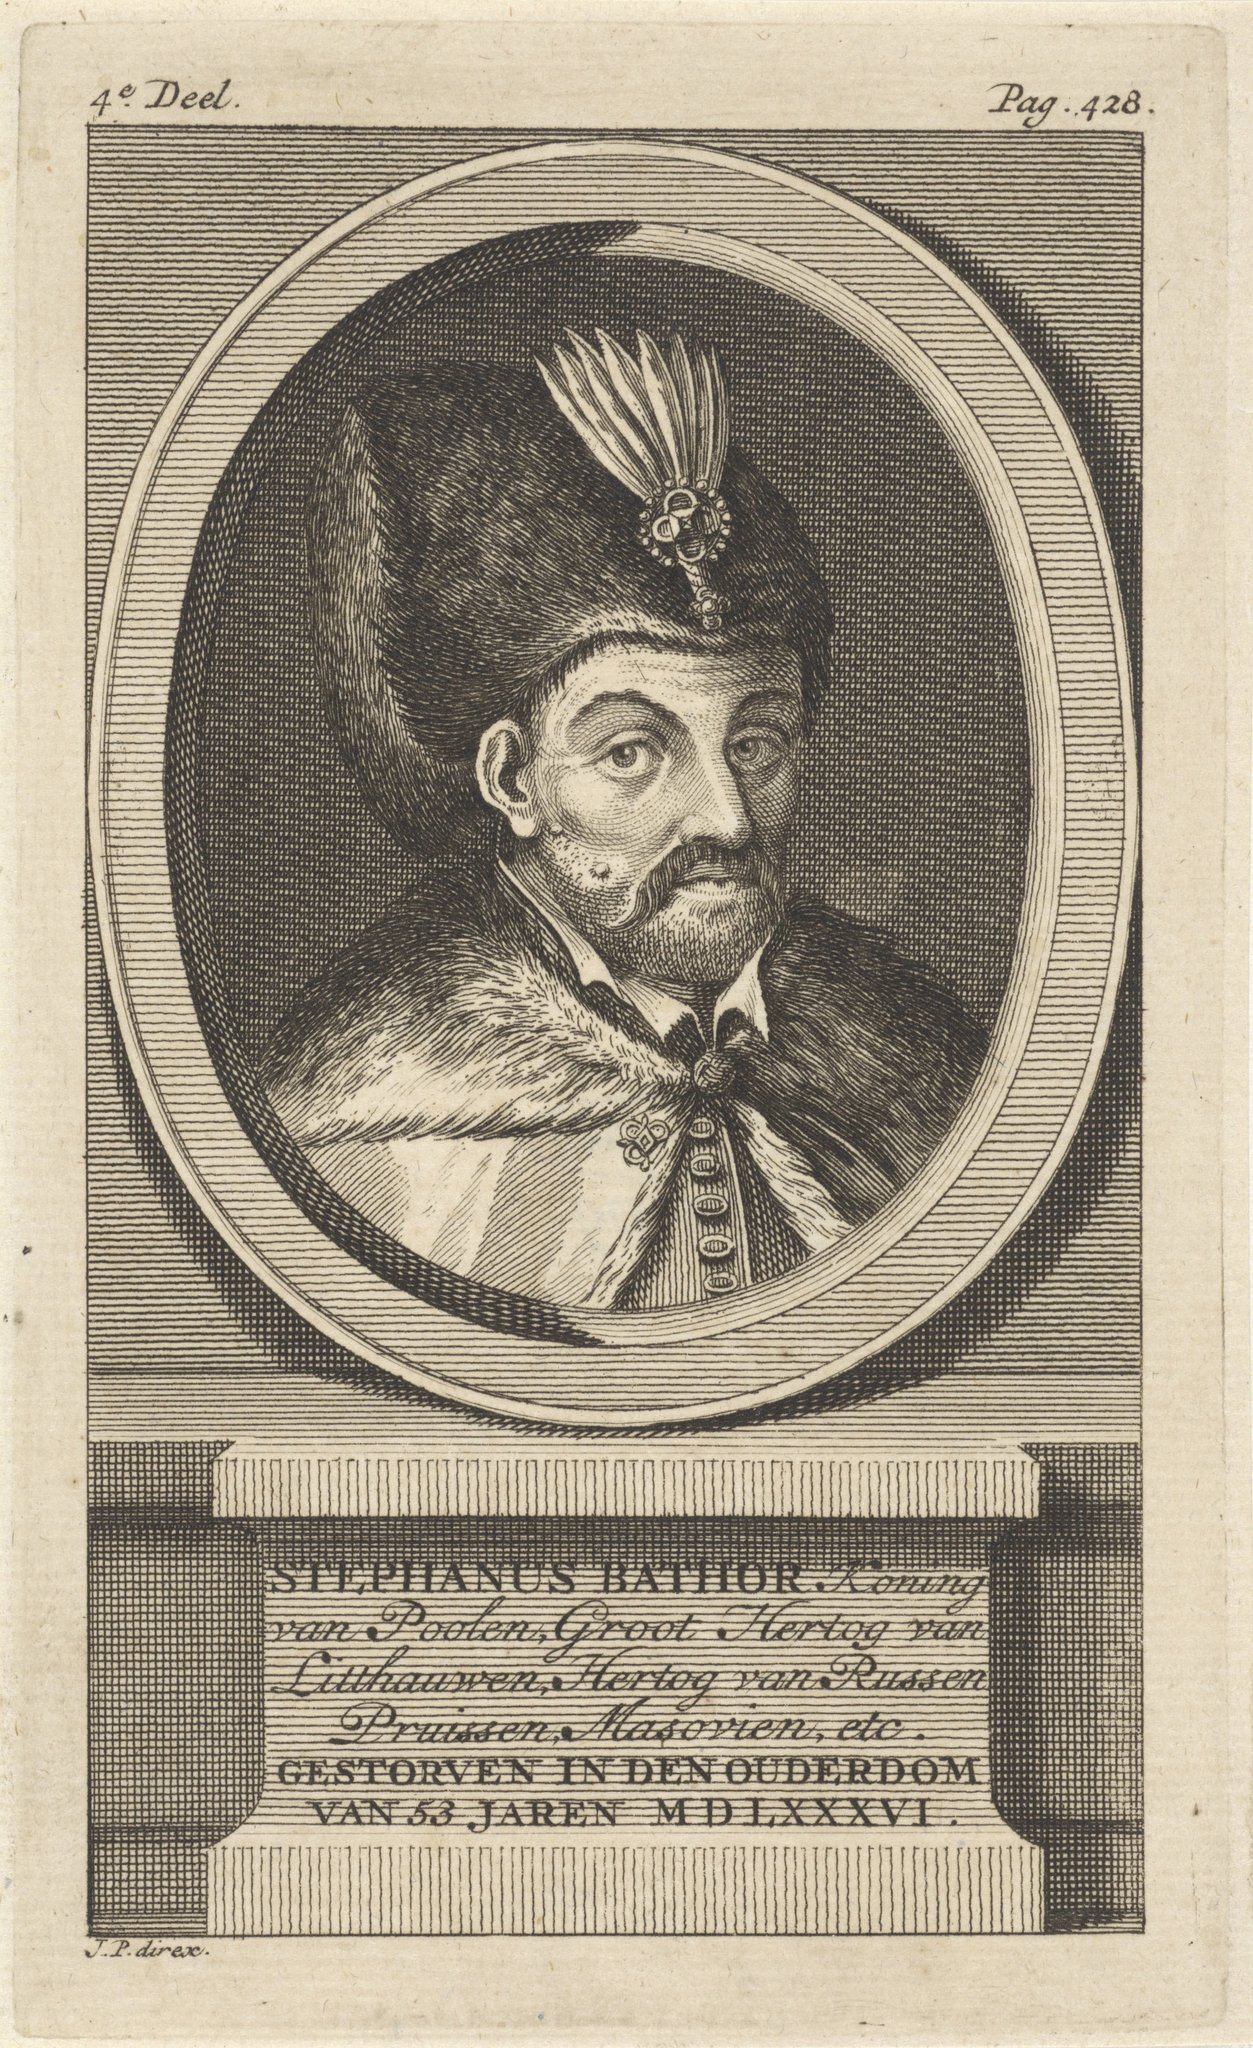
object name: print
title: Portret van Stefanus Báthory, koning van Polen en grootvorst van Litouwen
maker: jan punt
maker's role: draughtsman, print maker, publisher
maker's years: 1711-1779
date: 1751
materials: paper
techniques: engraving, etching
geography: northern netherlands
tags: şimleu silvaniei, stefanus báthory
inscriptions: collector's mark: Lugt 2228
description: Illustratie uit: Meteren, Emanuel van. Historie van de oorlogen en geschiedenissen der Nederlanderen, en der zelver naburen: beginnende met den jare 1315, en eindigende met den jare 1611, deel IV, p. 428. Gorinchem: Nicolaas Goetzee, 1751.